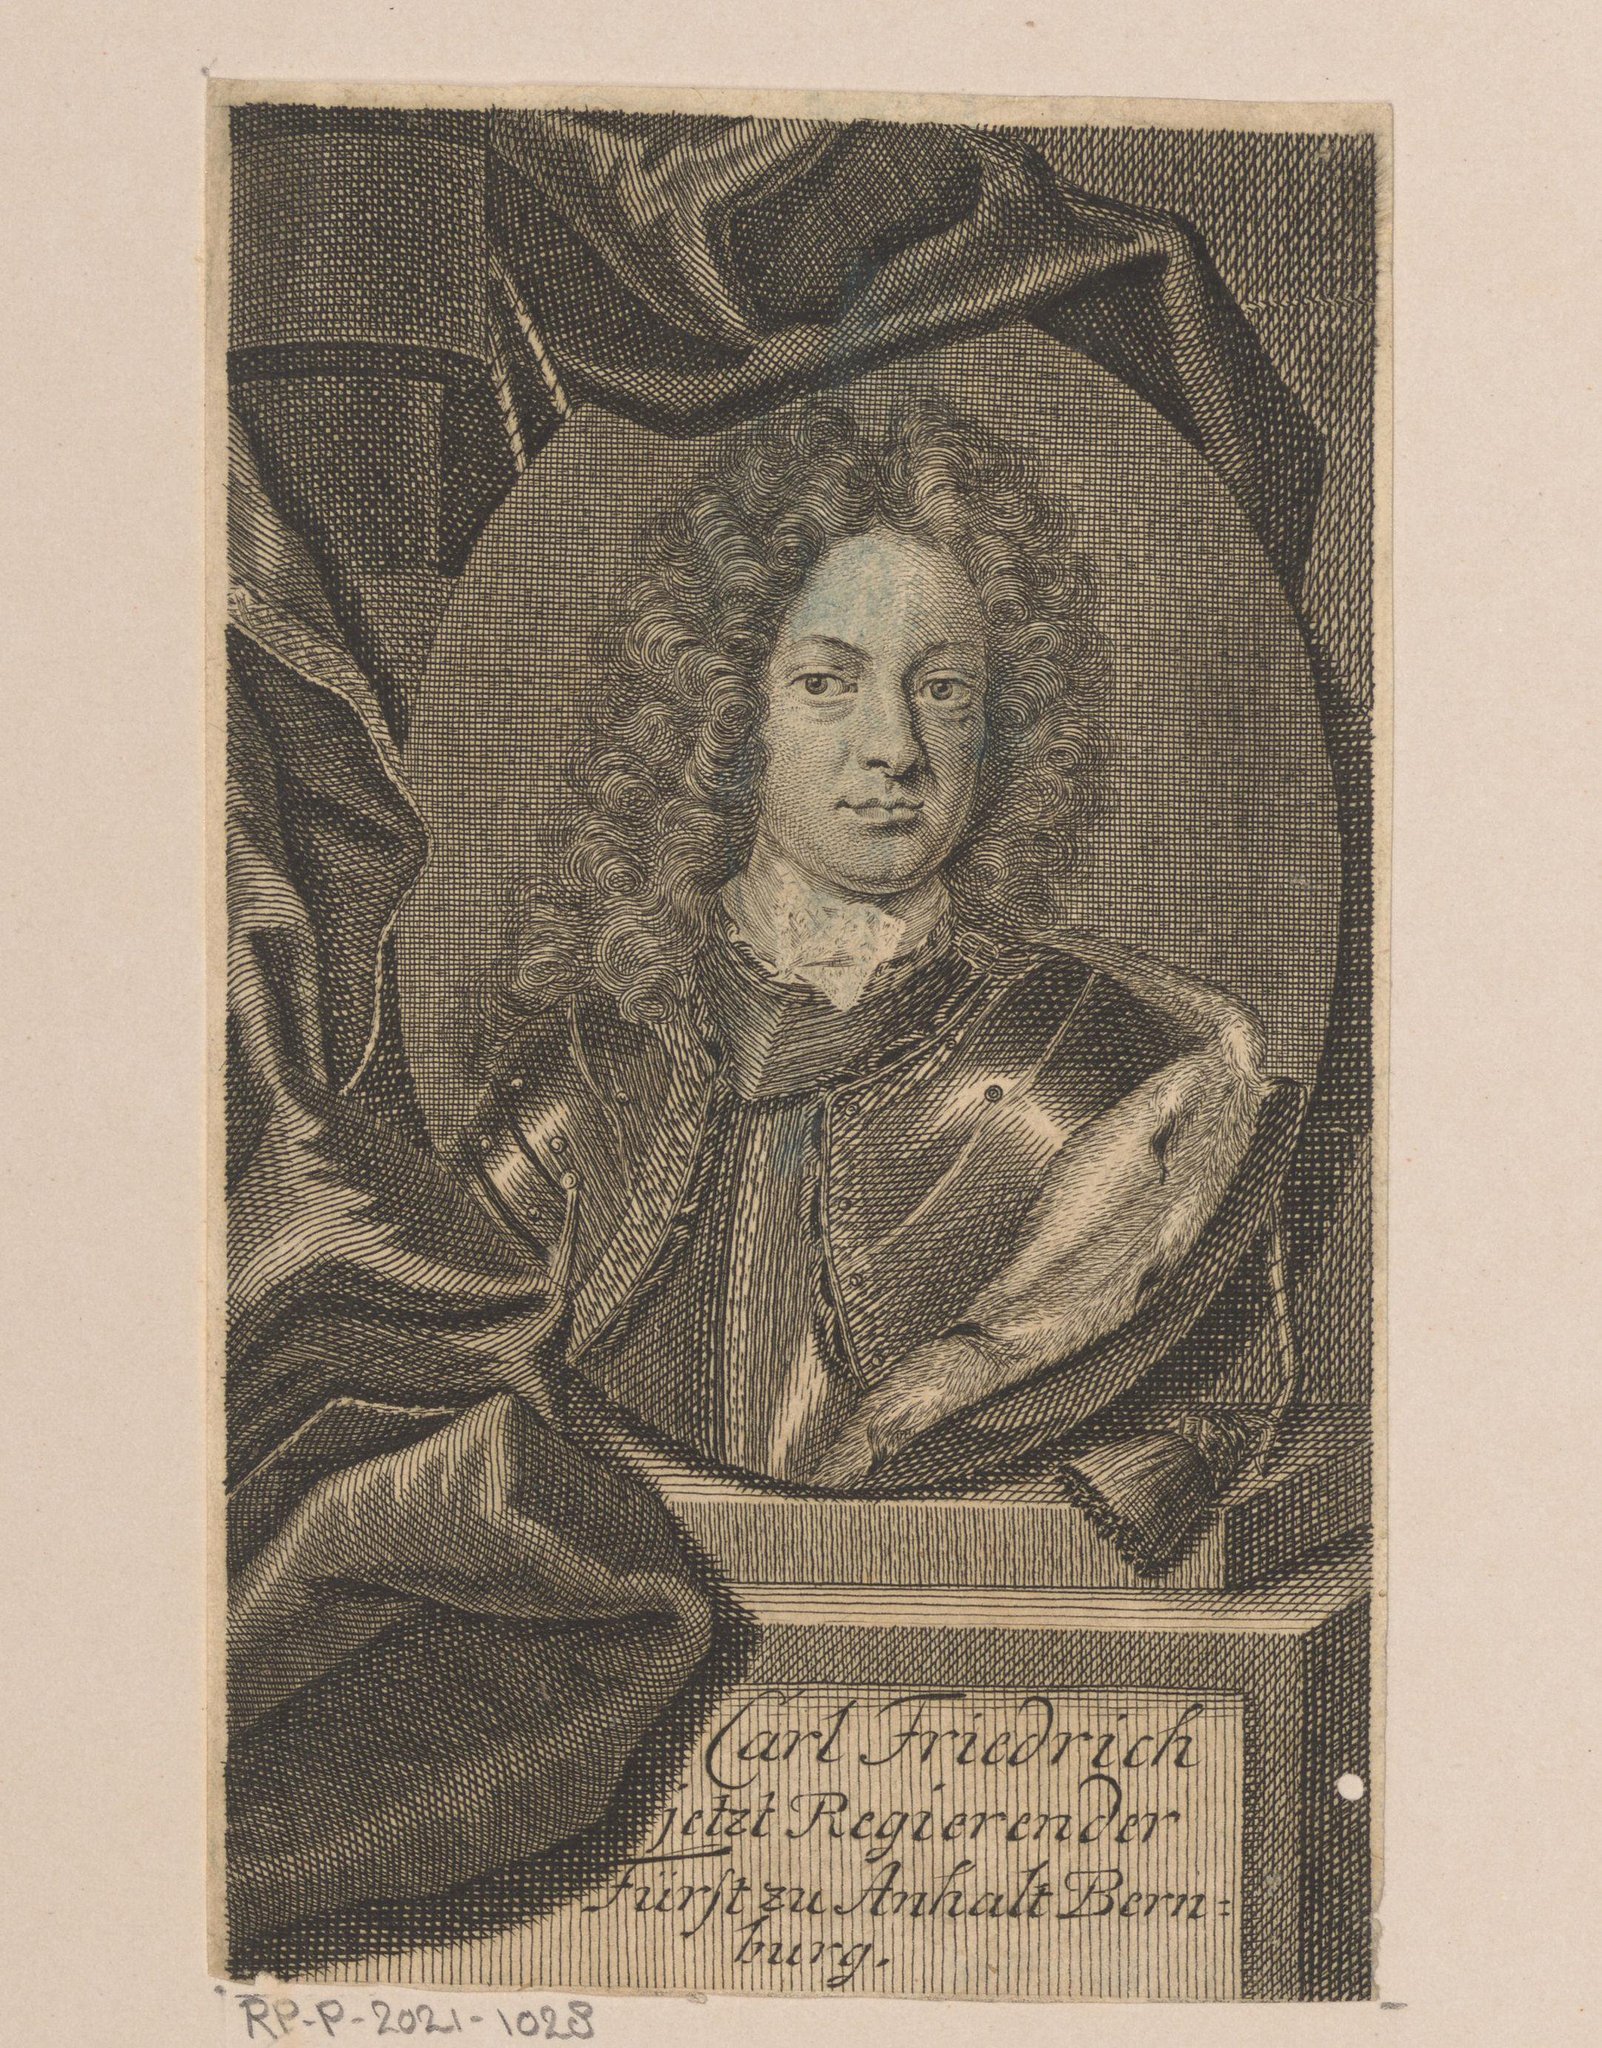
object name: print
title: Portret van Karl Friedrich von Anhalt-Bernburg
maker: Anonymous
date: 1718-1721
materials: paper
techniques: engraving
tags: armour, historical persons, ruler, sovereign